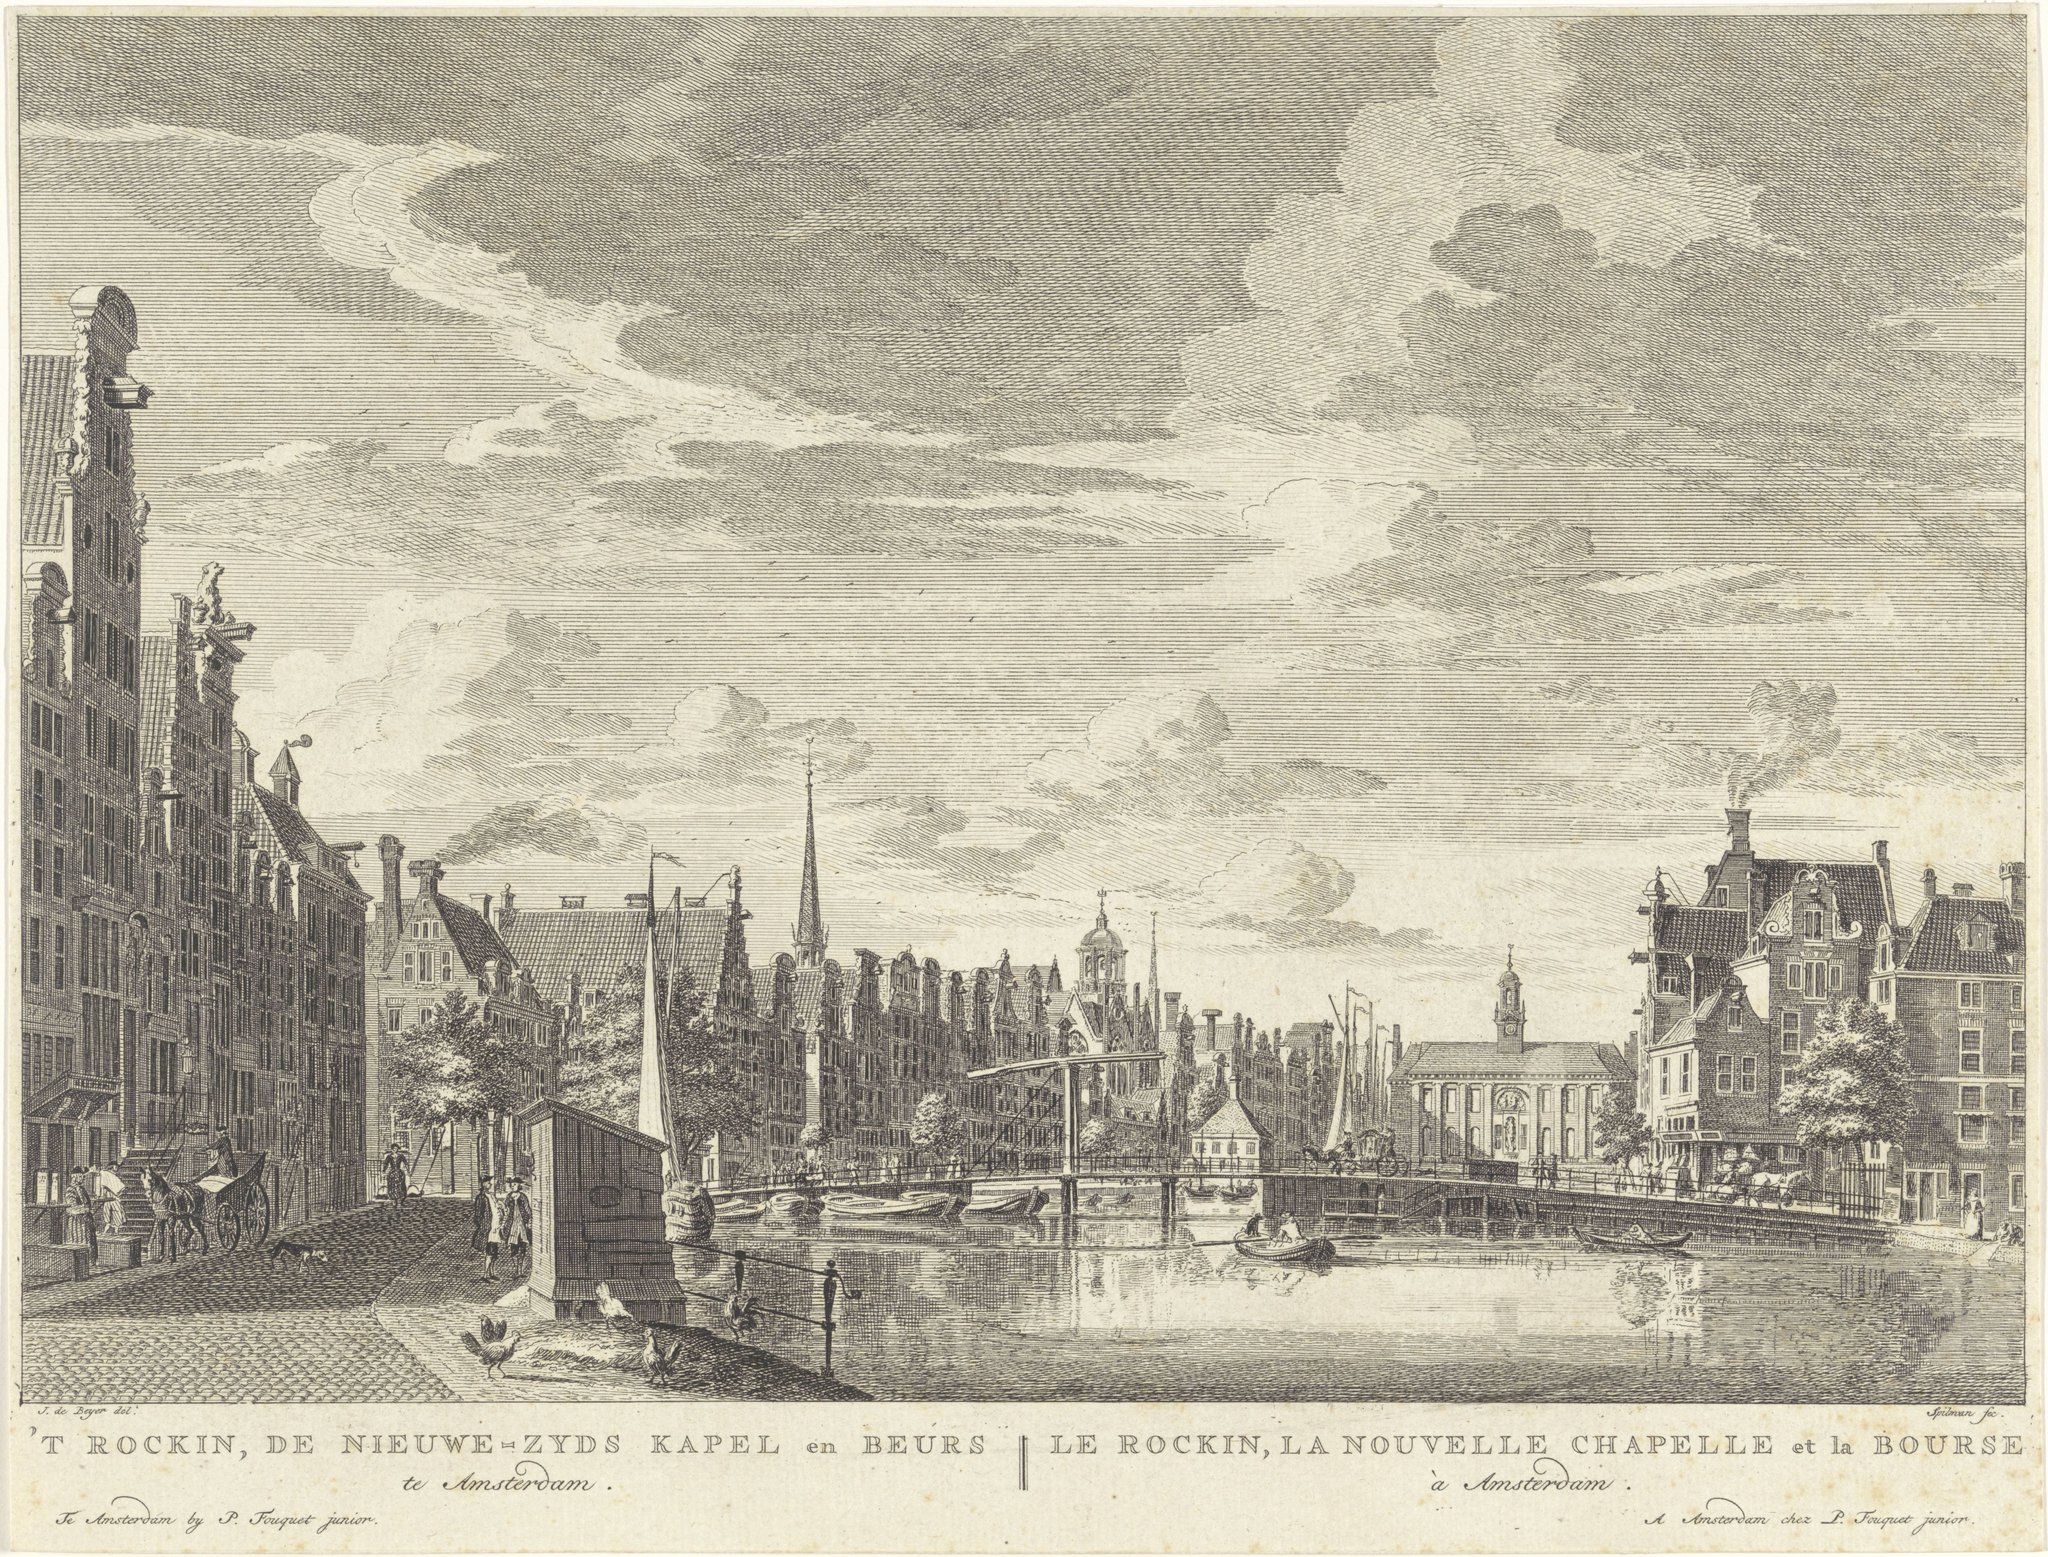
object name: print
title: 't Rockin, de Nieuwe-Zyds Kapel en Beurs te Amsterdam/ Le Rockin, la Nouvelle Chapelle et la Bourse à Amsterdam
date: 1760-1783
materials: paper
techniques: engraving, etching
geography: haarlem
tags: bridge in city across river, canal, etc. (+ city(-scape) with figures, staffage), stock exchange, stock-market, church (exterior) - qq - small church, chapel, canals, waters (in city) (+ city(-scape) with figures, staffage), street (+ city(-scape) with figures, staffage)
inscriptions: collector's mark: Lugt 2228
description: Deze prent is ook gebruikt in de zogenaamde Atlas van Fouquet.* Pierre Fouquet gaf vanaf 1760 stadsgezichten van Amsterdam - naar tekeningen van verschillende kunstenaars, gemaakt door verschillende prentmakers - uit. Deze prenten werden aanvankelijk los of in series verkocht. Zoals toen gebruikelijk kon de koper de prenten zelf laten inbinden. Hiertoe gaf Fouquet tussen 1778 en 1783 een titelblad, plattegrond en inhoudsopgave van de tot dusver 100 uitgegeven prenten uit (1). Gezien de inhoud afhankelijk was van wat de koper had verzameld verschilt de inhoud van de verschillende bewaarde Fouquetatlassen onder deze titel sterk. Ook zijn er exemplaren bekend waar tevens andere prenten aan zijn toegevoegd. Omdat er behoefte bleek aan uitleg bij de platen werd in 1783 een nieuwe versie van de atlas uitgegeven, aangevuld met tekst en twee prenten. De aangegeven volgorde veranderde maar de platen van de al eerder uitgegeven prenten bleven ongewijzigd. Deze uitgave werd in opdracht van Fouquet gedrukt bij Daniël Jean Changuion en Petrus den Hengst (2). Een tiental platen werd bijgewerkt en verscheen, met nieuw impressum, in het vervolg van Wagenaars geschiedenis van Amsterdam, uitgeven door Petrus Conradi en Folkert van der Plaats (3). Een aantal jaar na het overlijden van Fouquet kwam Evert Maaskamp met een nieuwe uitgave van de atlas, met verbeterde tekst en toevoeging van twee prenten. Op alle platen verwijderde hij het oude en liet hij zijn eigen impressum zetten (4). De huidige staat van de prent komt voor in exemplaren van de onder (1) en (2) genoemde werken. * Onder de Atlas van Fouquet of Fouquetatlas verstaan we de hieronder vermelde publicaties (1), (2) en (4). (1). Afbeeldingen van de wyd-vermaarde koopstad Amsterdam benevens des zelvs voornaamste gebouwen en gezigten alle naar het leeven getekend / Receuil des edifices les plus considerables et des plus belles vues, de la fameuse ville d'Amsterdam, dessinées d'après nature. Amsterdam: Pierre Fouquet, 1778-1783. (2). Nieuwe atlas, van de voornaamste gebouwen en gezigten der stad Amsterdam, met derzelver beknopte beschryvingen. 2 delen. Amsterdam: Daniël Jean Changuion en Petrus den Hengst [in opdracht van Pierre Fouquet], 1783. (3). Stijl, Simon. Amsterdam, in zyne geschiedenissen, voorregten, koophandel, gebouwen, kerkenstaat, schoolen, schutterye, gilden en regeeringe, beschreeven. Om te dienen ten vervolge op het werk van Jan Wagenaar (…). 10 delen. Amsterdam en Harlingen: Petrus Conradi en Folkert van der Plaats, 1788-1801. (4). Nieuwe atlas, van de voornaamste gebouwen en gezigten der stad Amsterdam. Met derzelver beknopte beschryvingen. Amsterdam: Evert Maaskamp, 1805. * Het aantal vermelde staten is gebaseerd op het aantal gevonden staten. Mogelijk zijn er meer staten van deze prent. Zie RP-P-AO-25-82 voor latere staat.